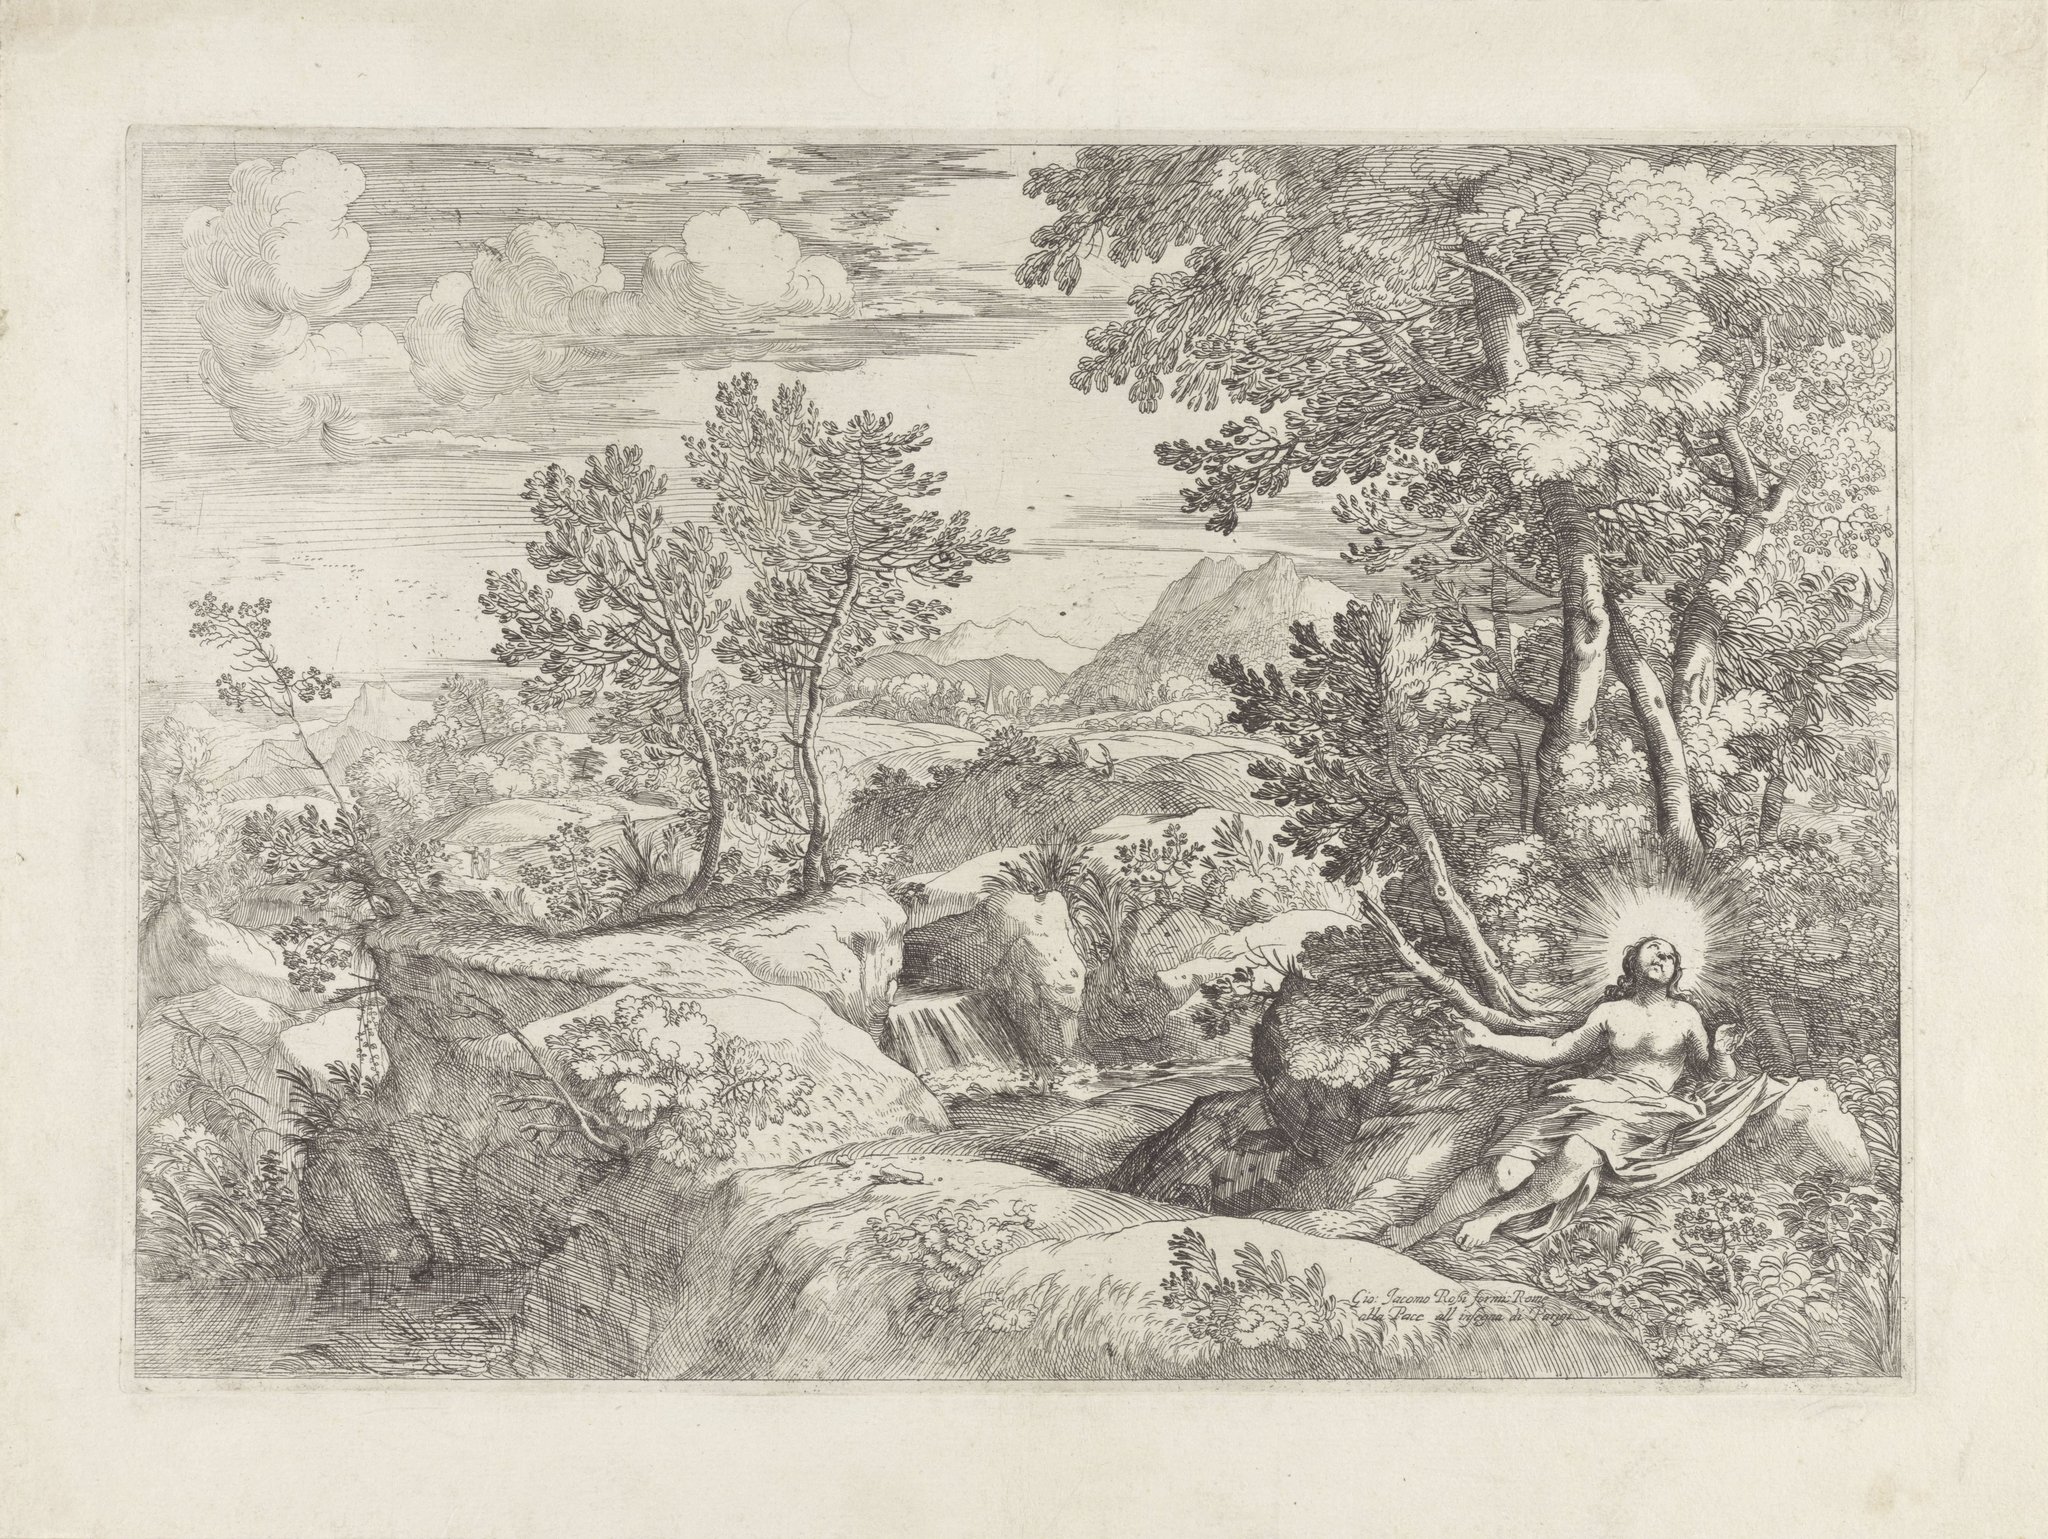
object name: print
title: Landschap met de boetvaardige Maria Magdalena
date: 1616-1680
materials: paper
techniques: etching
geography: rome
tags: landscapes, the penitent harlot mary magdalene; possible attributes: book (or scroll), crown, crown of thorns, crucifix, jar of ointment, mirror, musical instrument, palm-branch, rosary, scourge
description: Een weids landschap met op de voorgrond rechts de boetvaardige heilige Maria Magdalena onder een boom.